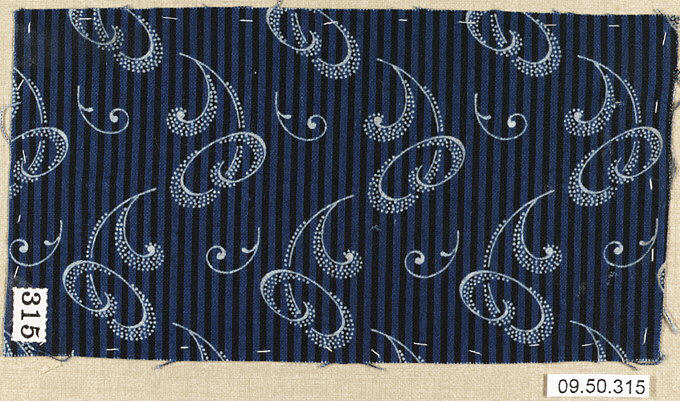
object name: piece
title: Piece (one of 116)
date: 1801-1900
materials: cotton